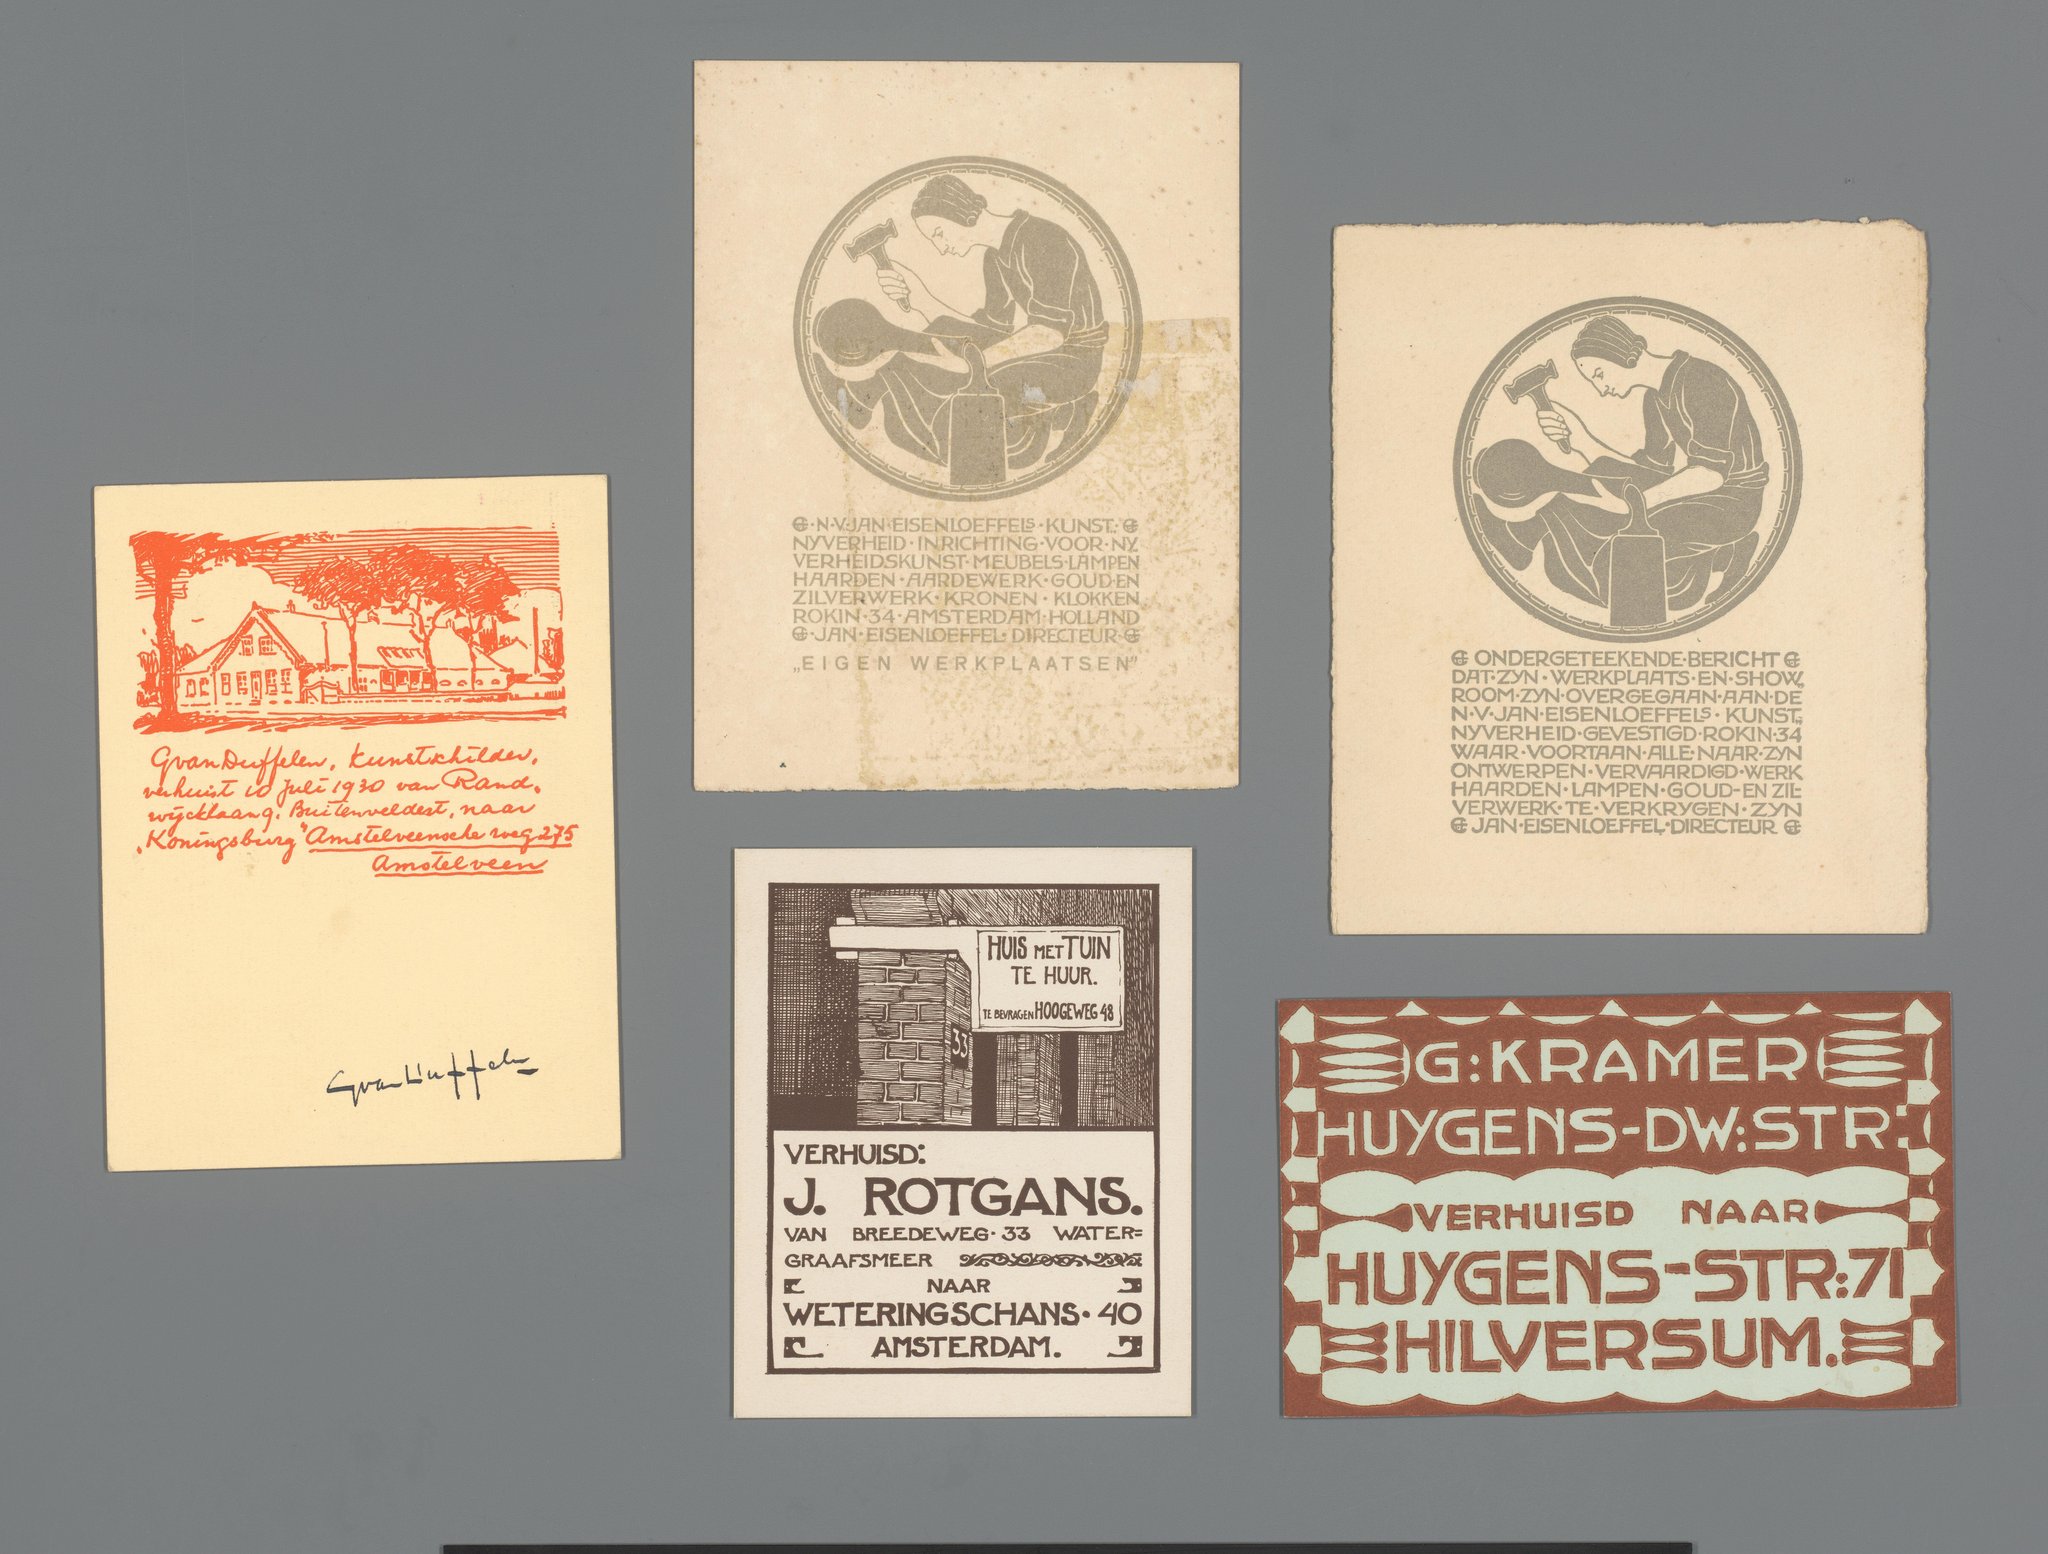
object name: postcard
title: Verhuisberichten van Gerrit van Duffelen, Jan Eisenloeffel, Jan Rotgans en G. Kramer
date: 1900-1955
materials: paper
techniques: photochemical processes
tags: rotterdam, print maker, gerrit van duffelen, draughtsman, silversmith, jan eisenloeffel, jan rotgans, smith, blacksmith, farm (building)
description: Verhuisberichten bijeengebracht door R.W.P. de Vries Jr.